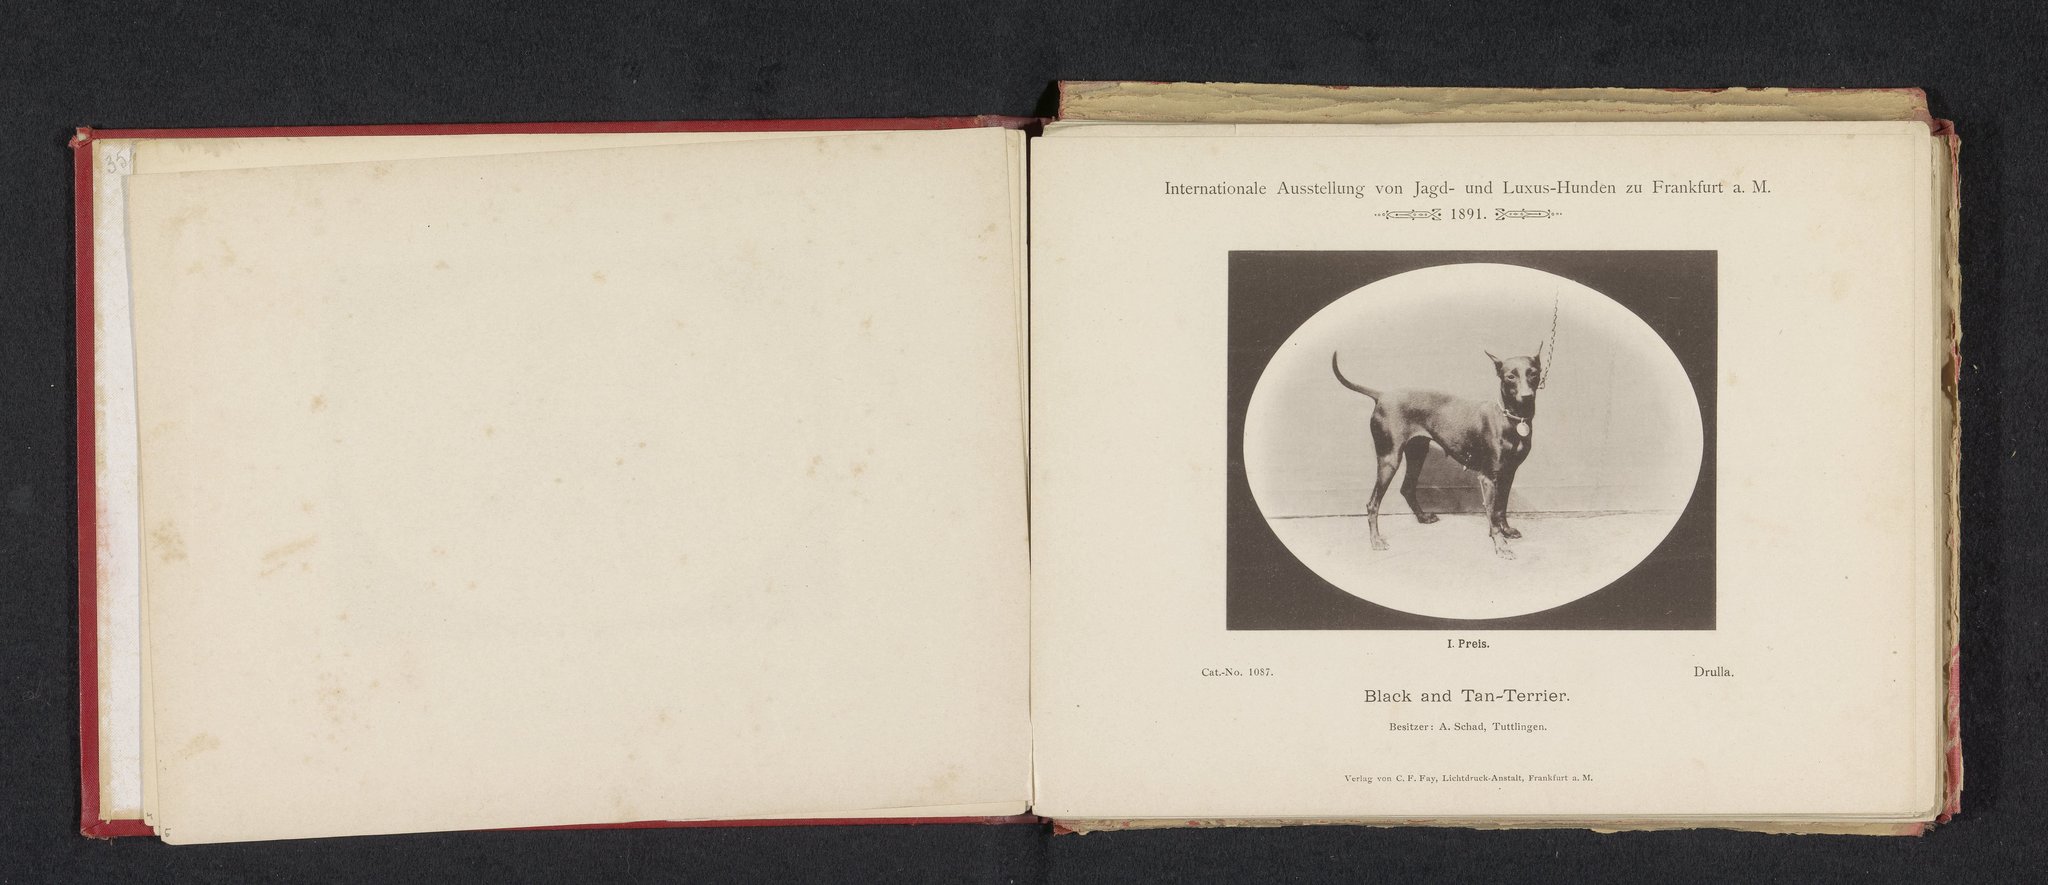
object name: page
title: Internationale Ausstellung von Jagd- und Luxus-Hunden zu Frankfurt a. M. 1891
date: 1891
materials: paper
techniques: photograph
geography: frankfurt am main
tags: dog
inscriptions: inscription: ‘I. Preis. Drulla. Besitzer : A. Schad, Tuttlingen.’, number: ‘Cat.-No. 1087.’